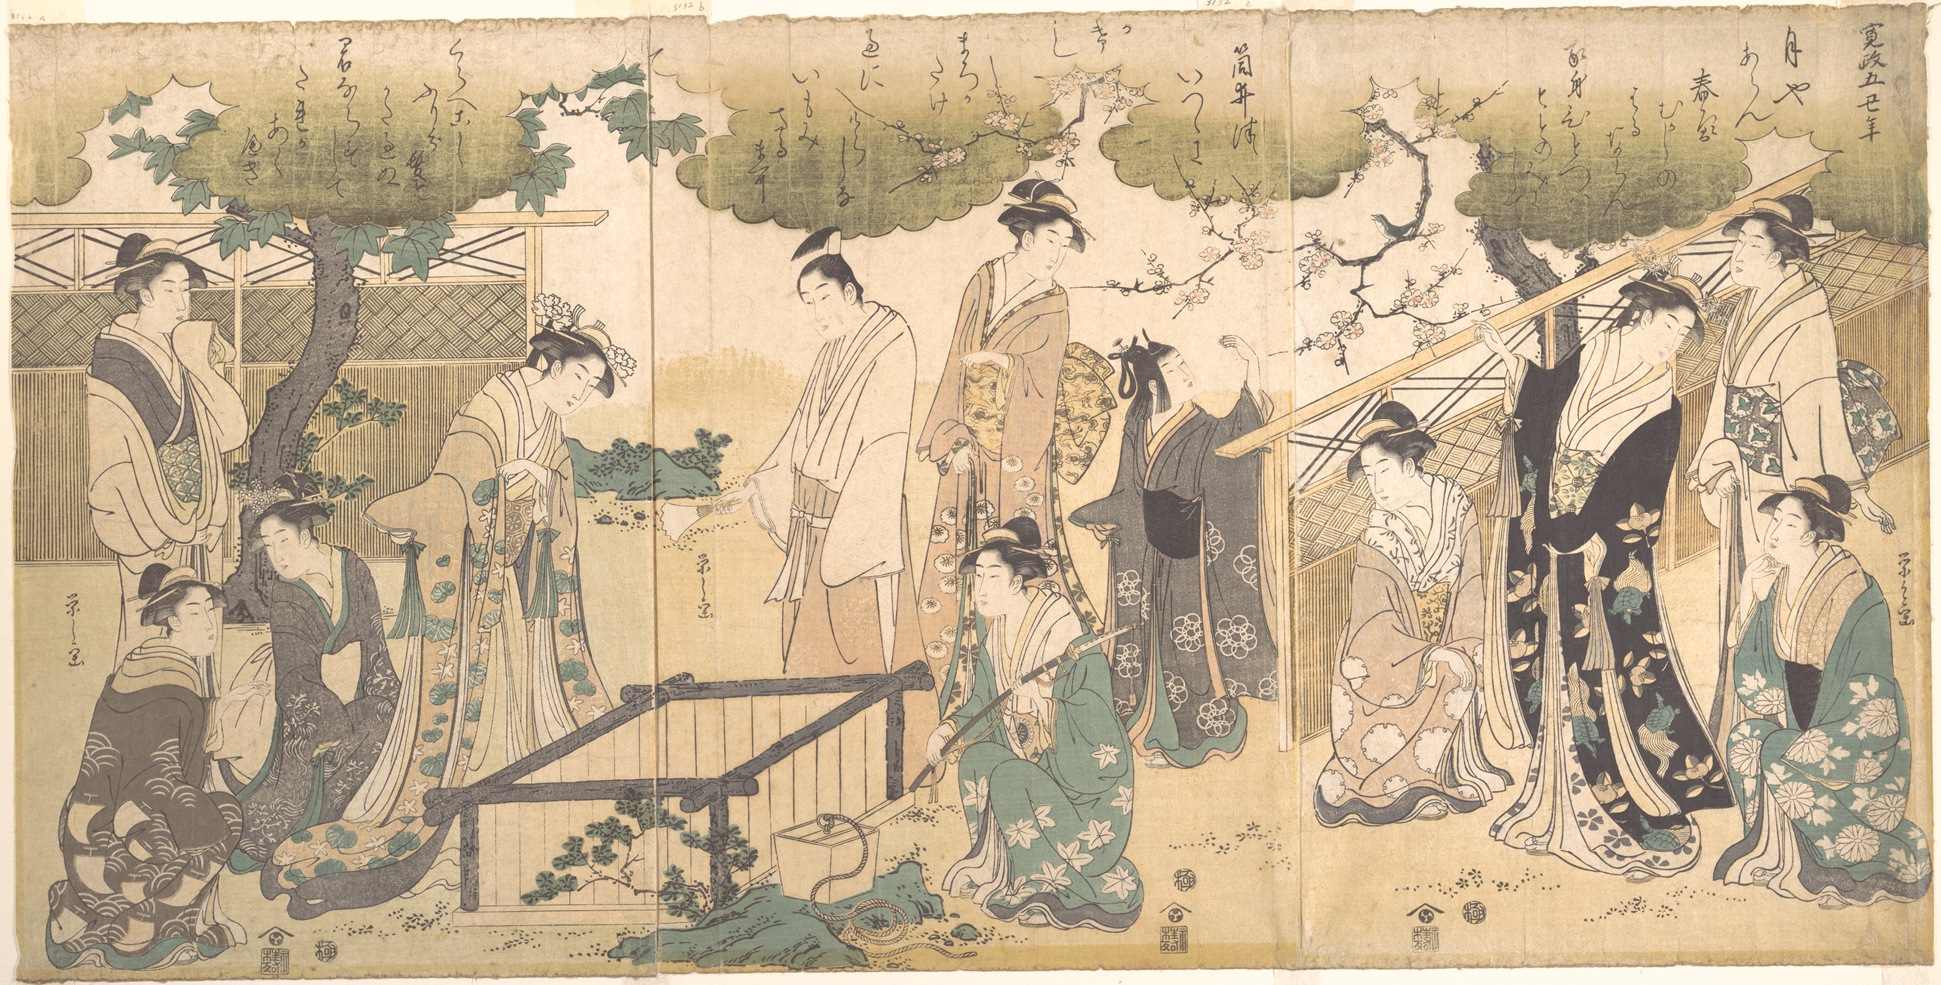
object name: print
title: At the Tsutsui Well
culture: japanese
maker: chōbunsai eishi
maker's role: artist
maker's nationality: japanese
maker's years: 1756-1829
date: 1781-1800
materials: ink, paper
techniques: woodblock print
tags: poetry,men,women